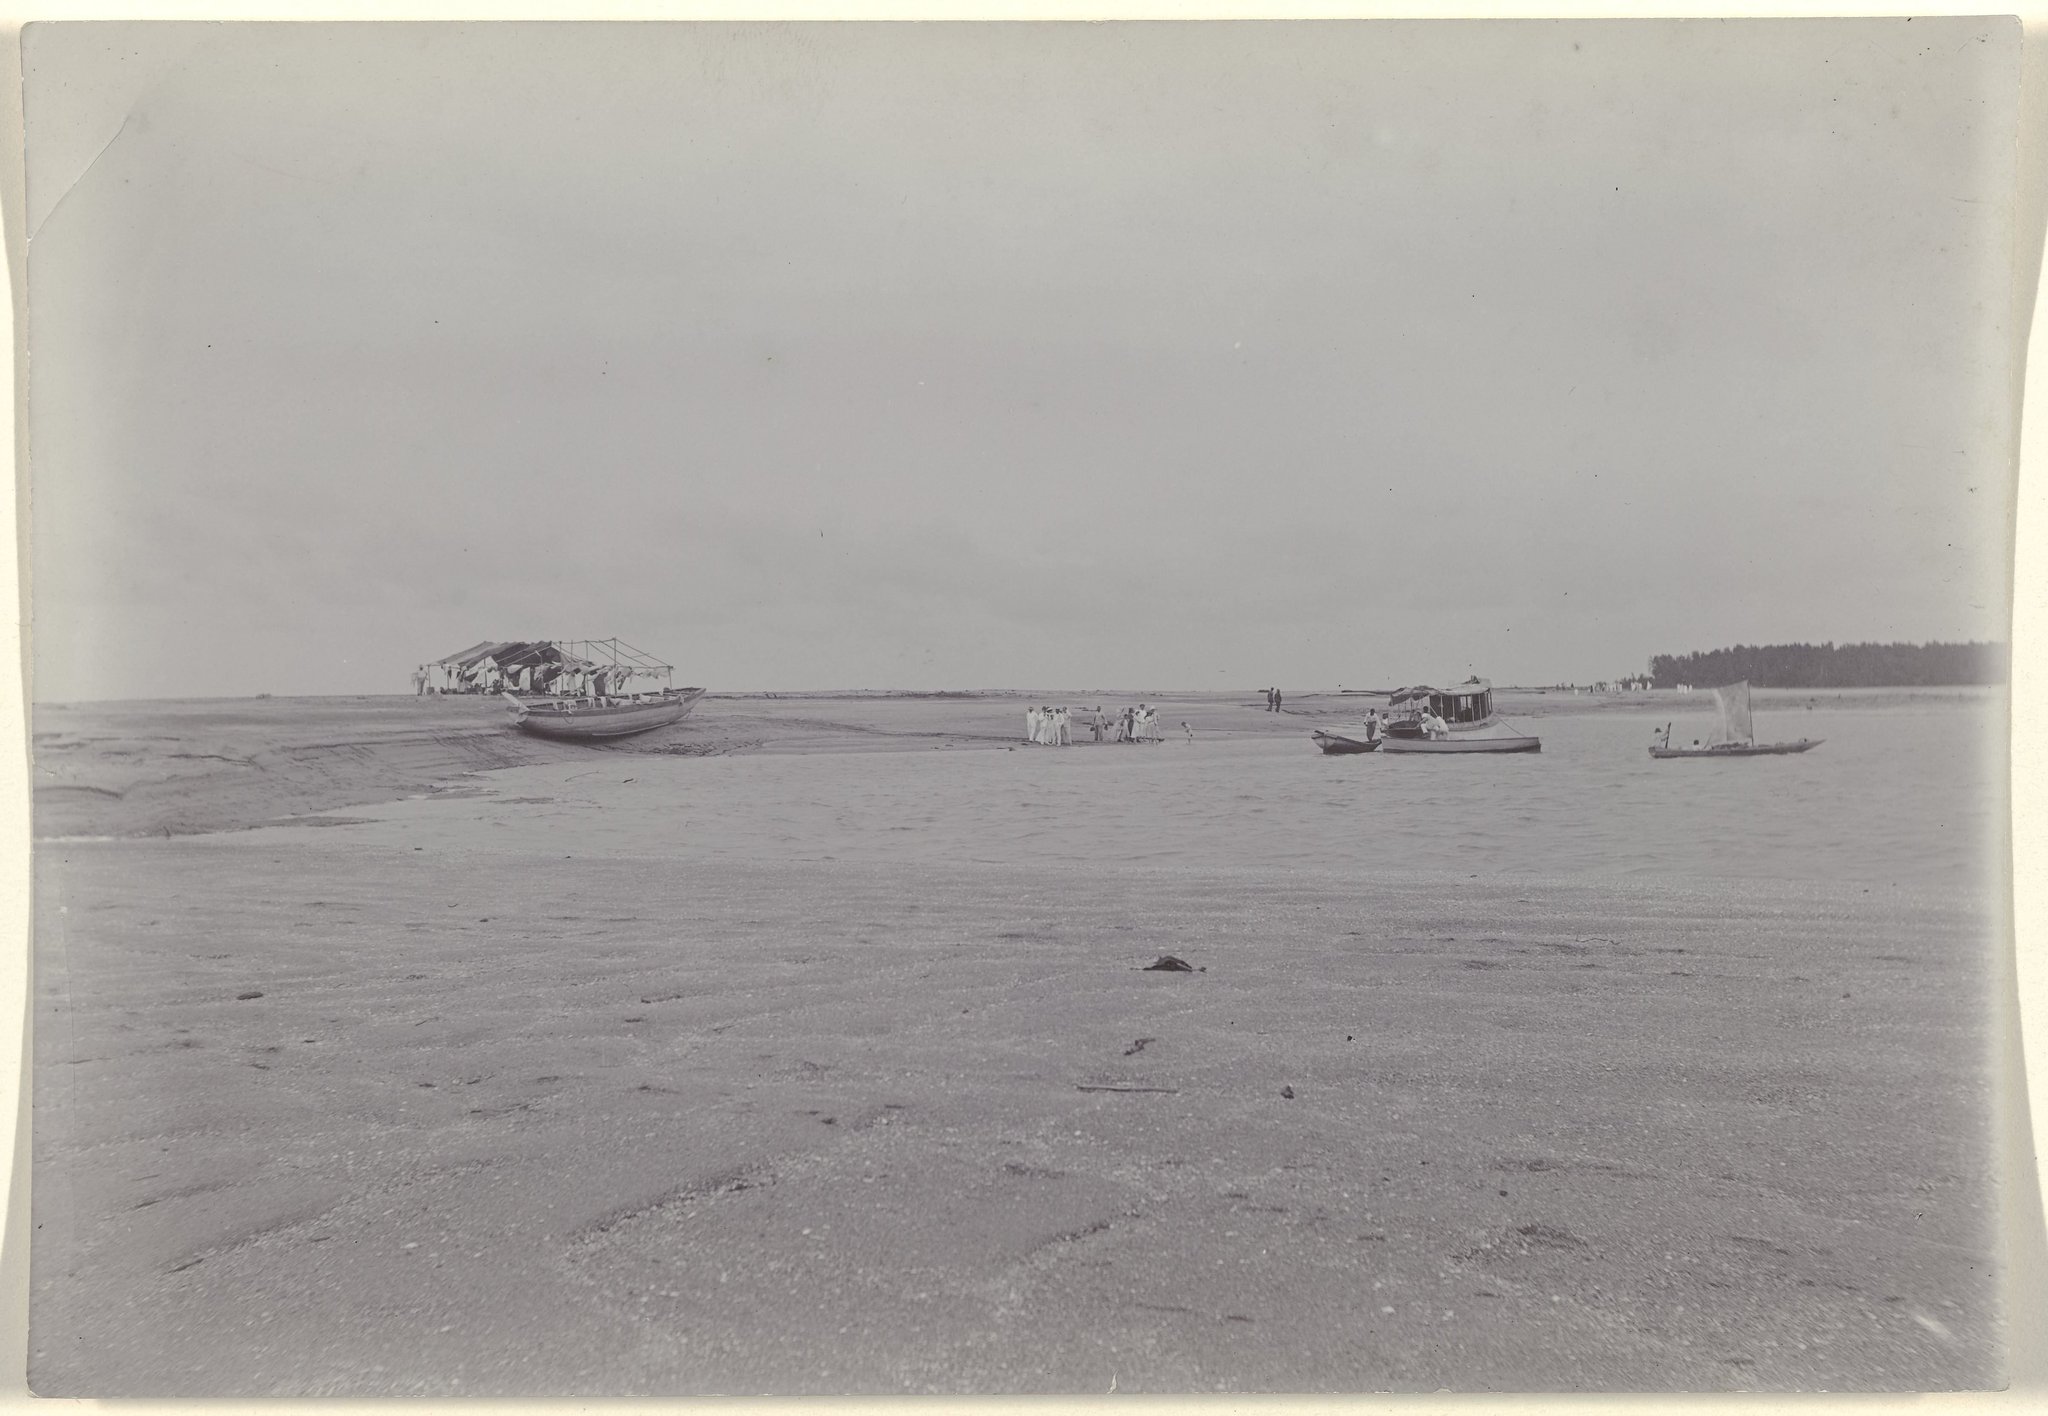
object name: photograph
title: Picknick aan het strand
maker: Anonymous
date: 1905-1910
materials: photographic support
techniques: photography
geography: suriname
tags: picnic, alfresco, 'déjeuner sur l'herbe', outing, pleasure trip, suriname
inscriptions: annotation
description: Drooggevallen rivierbedding of strand met bootjes en gezelschap. Picknick op het strand bij de Surinamerivier. Verschillende bootjes en een keet. Onderdeel van een groep objecten afkomstig van de familie Wesenhagen in Suriname.